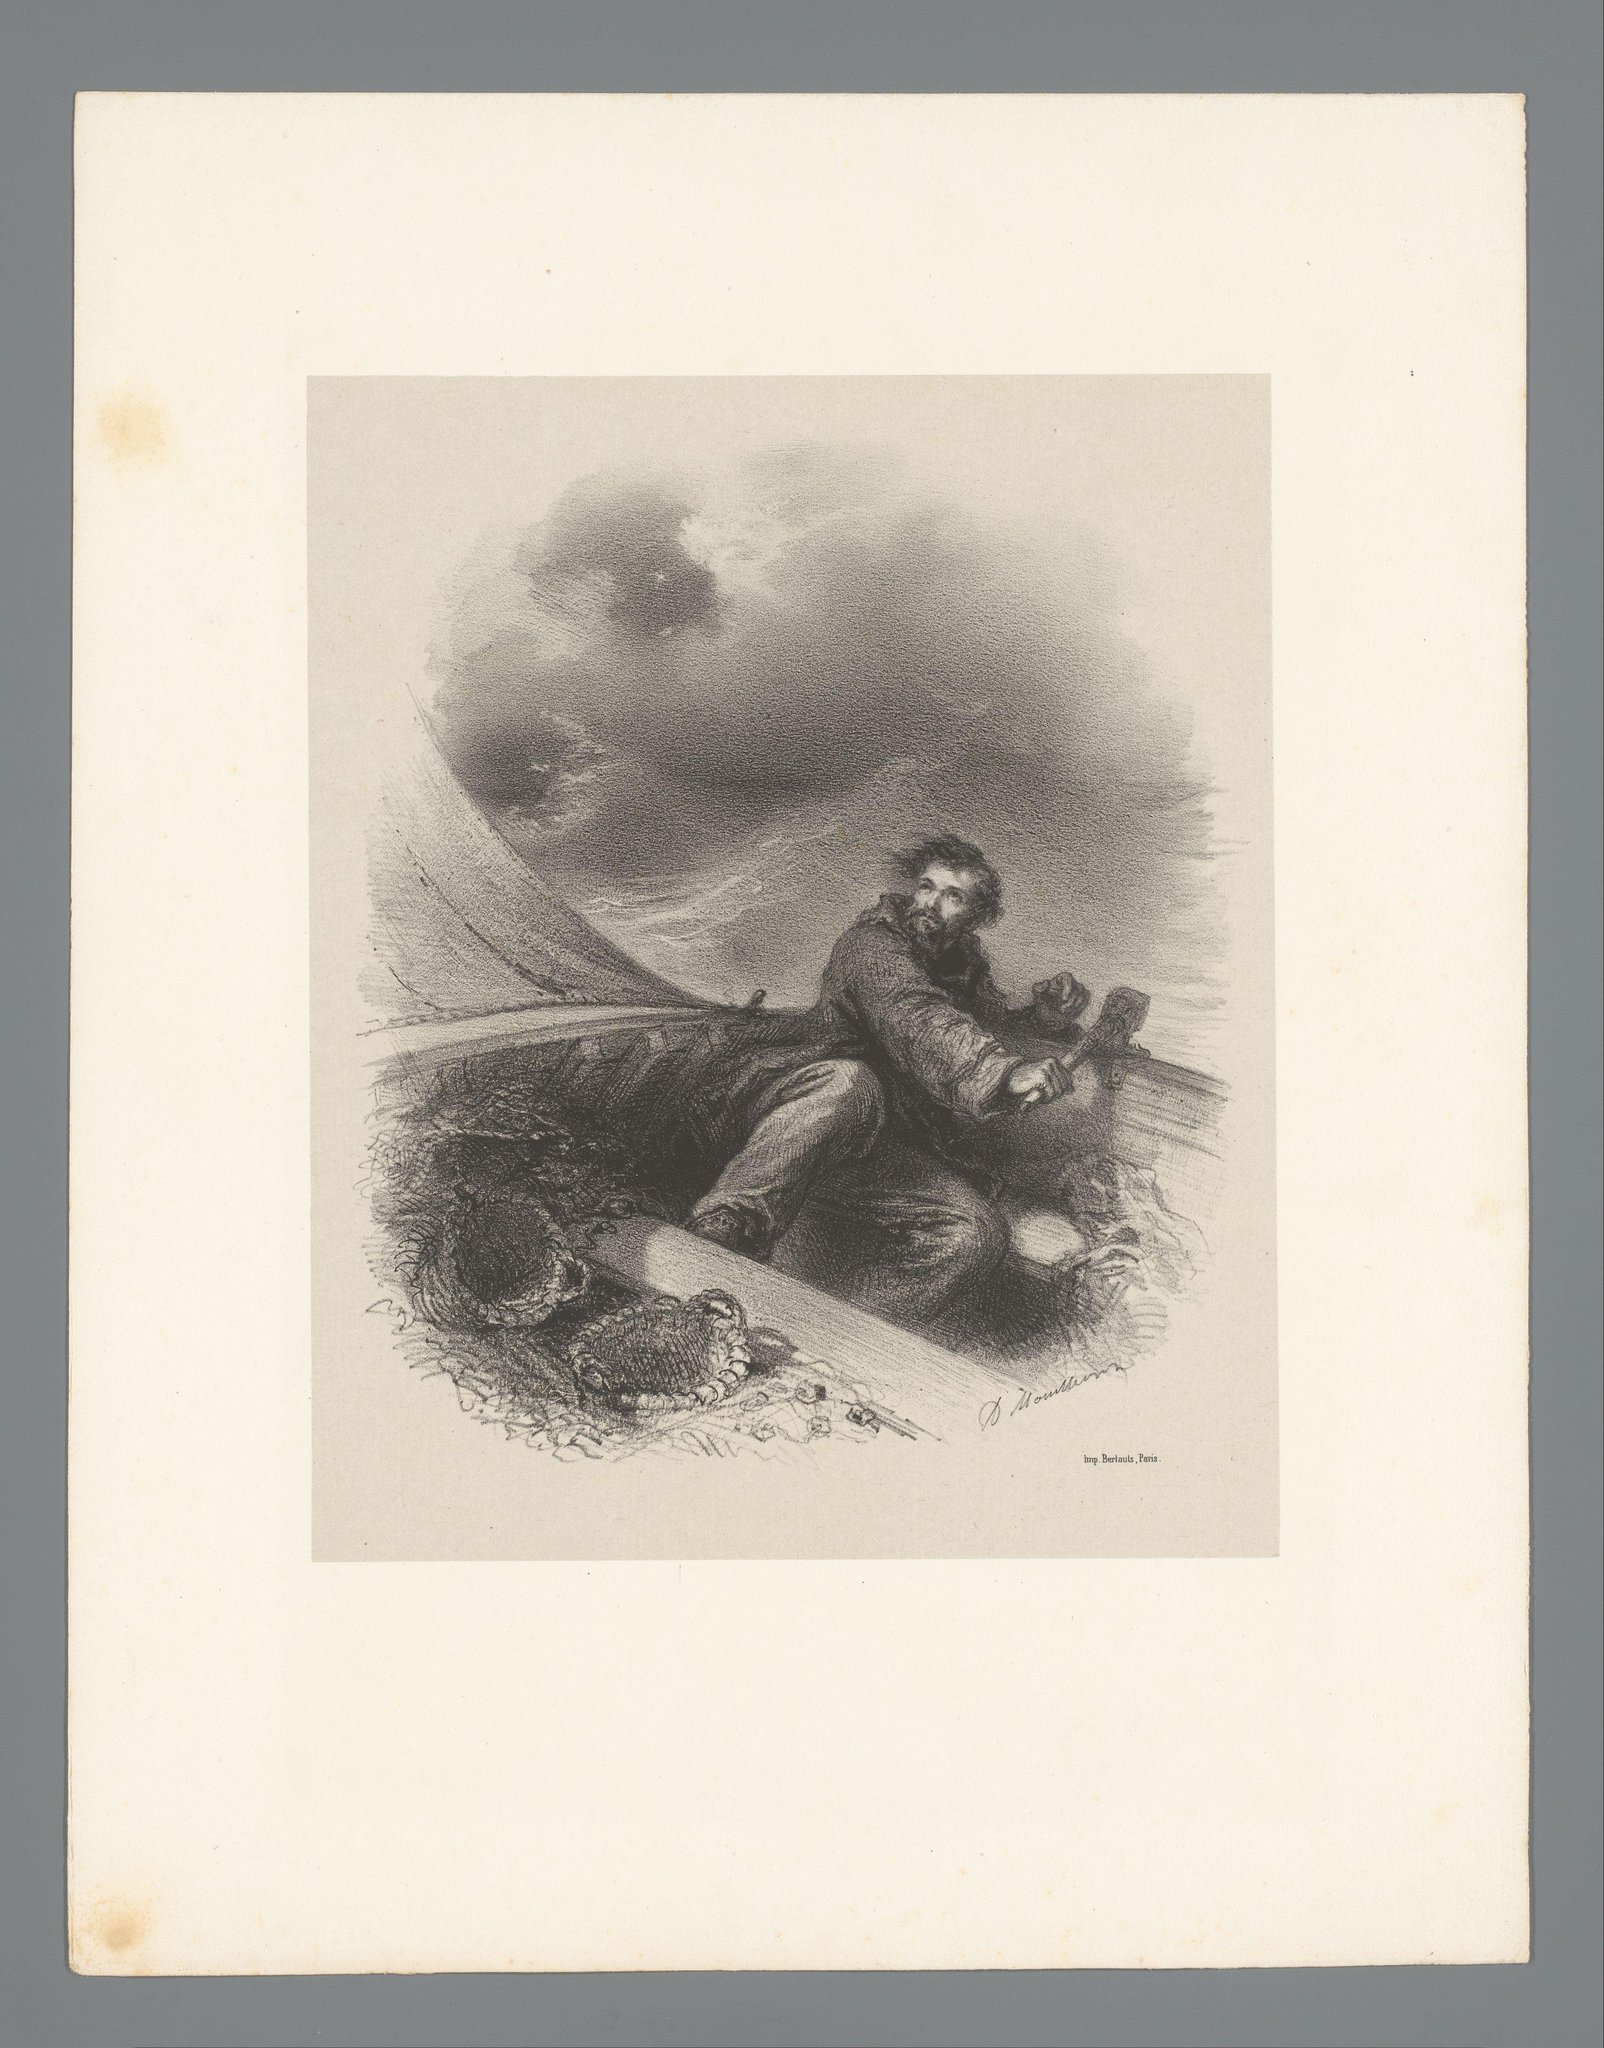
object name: print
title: Man aan het roer van een vissersboot op woest water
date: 1830-1880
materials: paper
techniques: lithograph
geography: paris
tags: storm, fisherman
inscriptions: collector's mark: Lugt 964